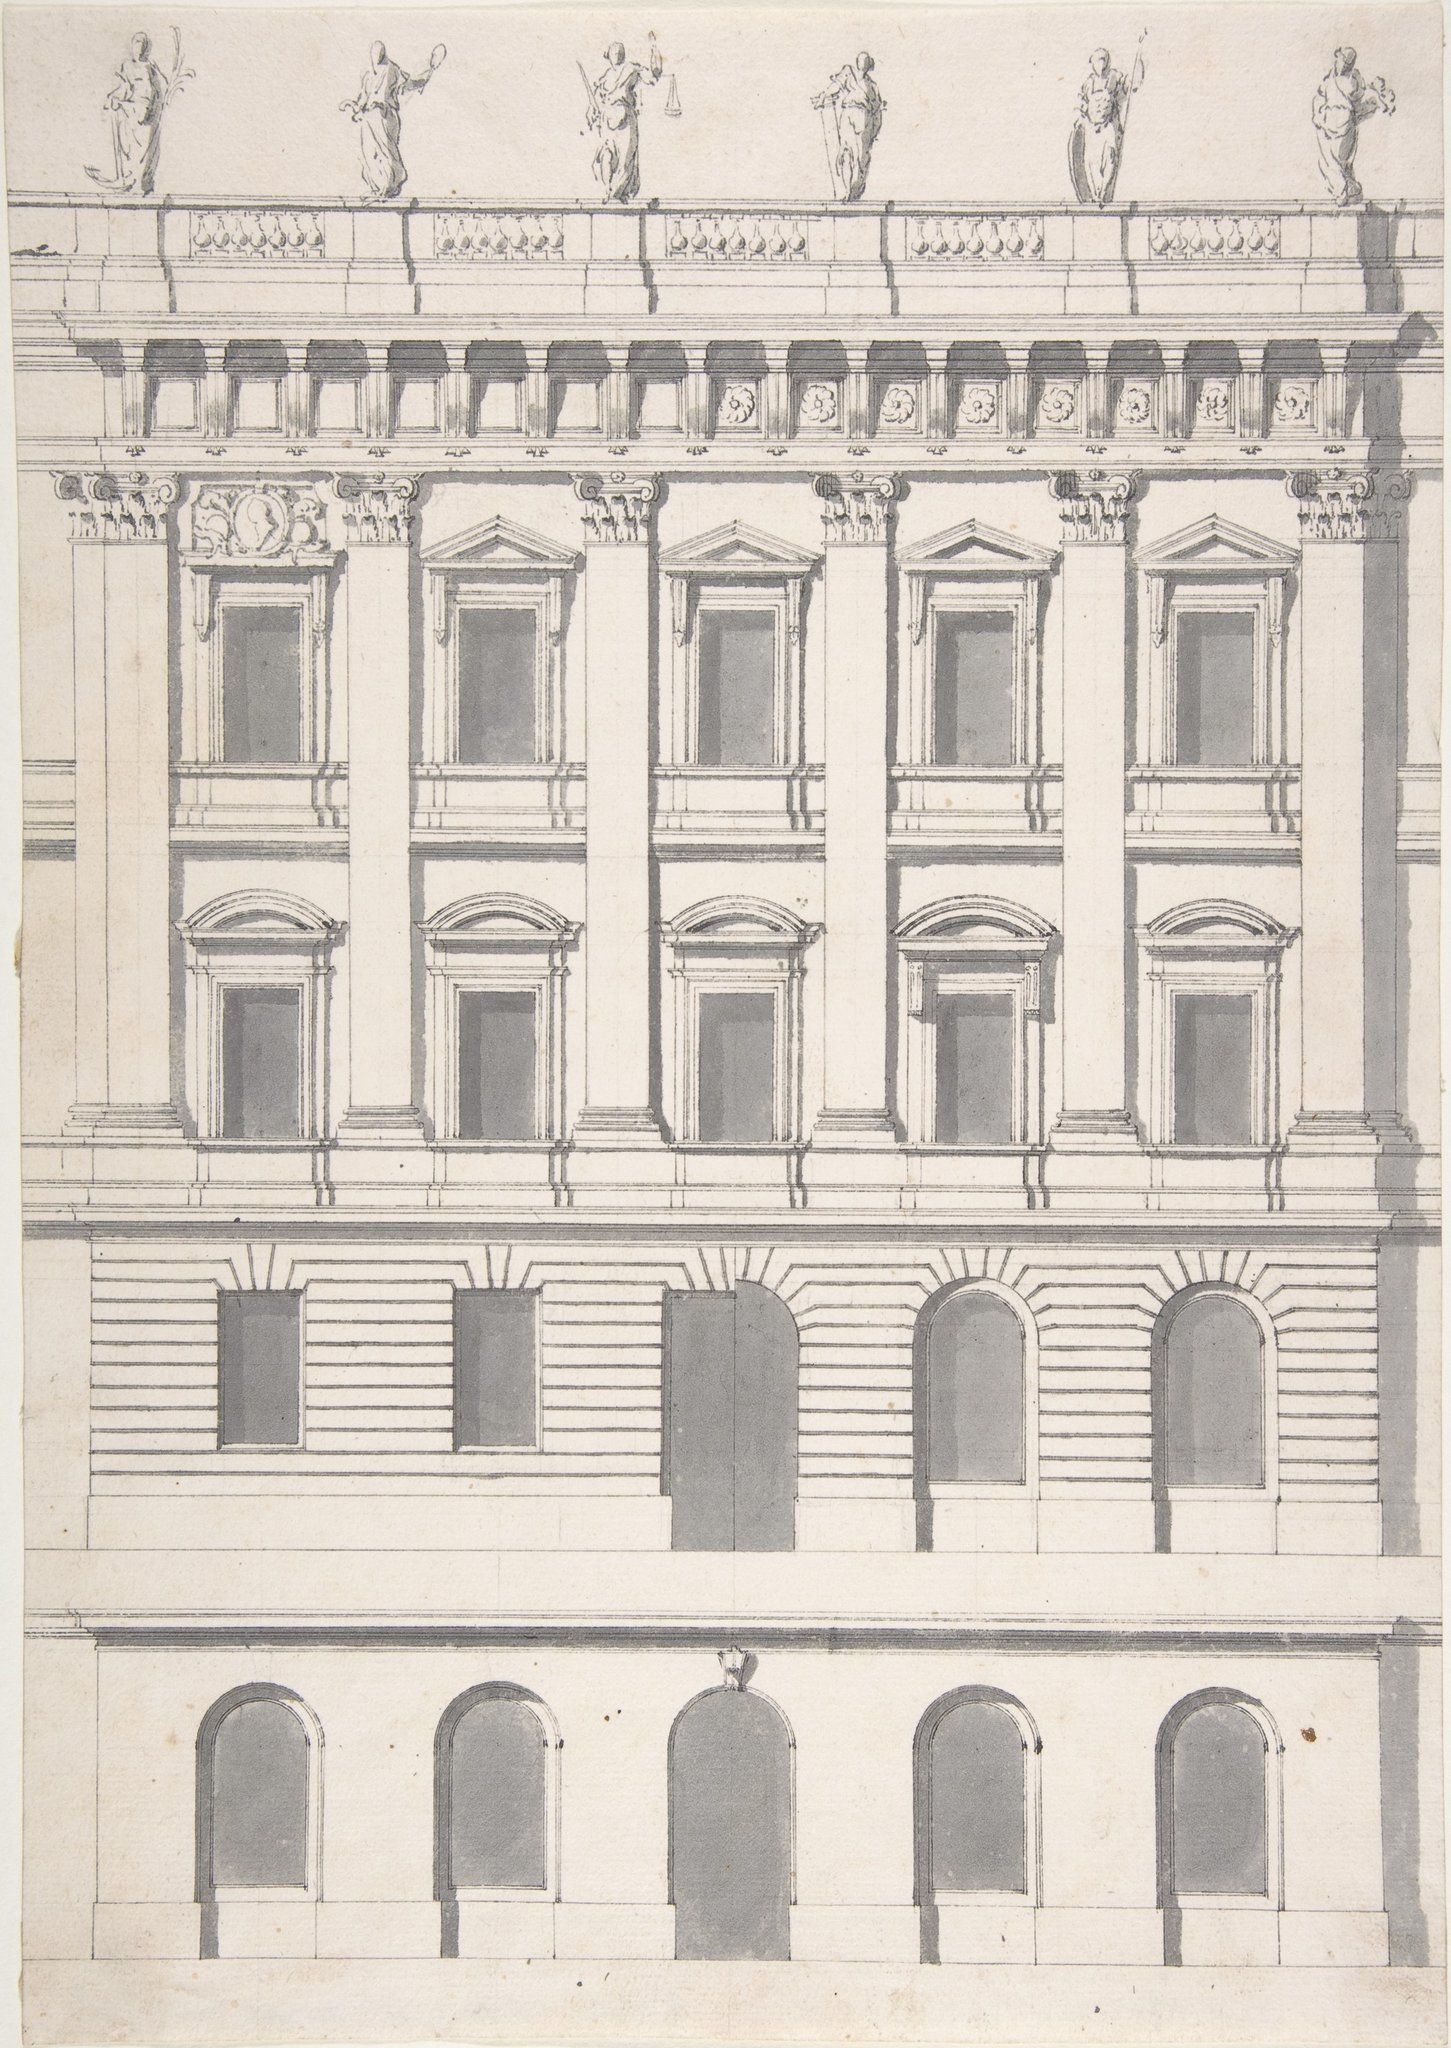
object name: drawing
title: Design for a Palace Façade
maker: carl hårleman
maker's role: artist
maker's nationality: swedish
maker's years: 1700-1753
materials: chalk, graphite, ink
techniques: brush, pen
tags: architecture,palaces